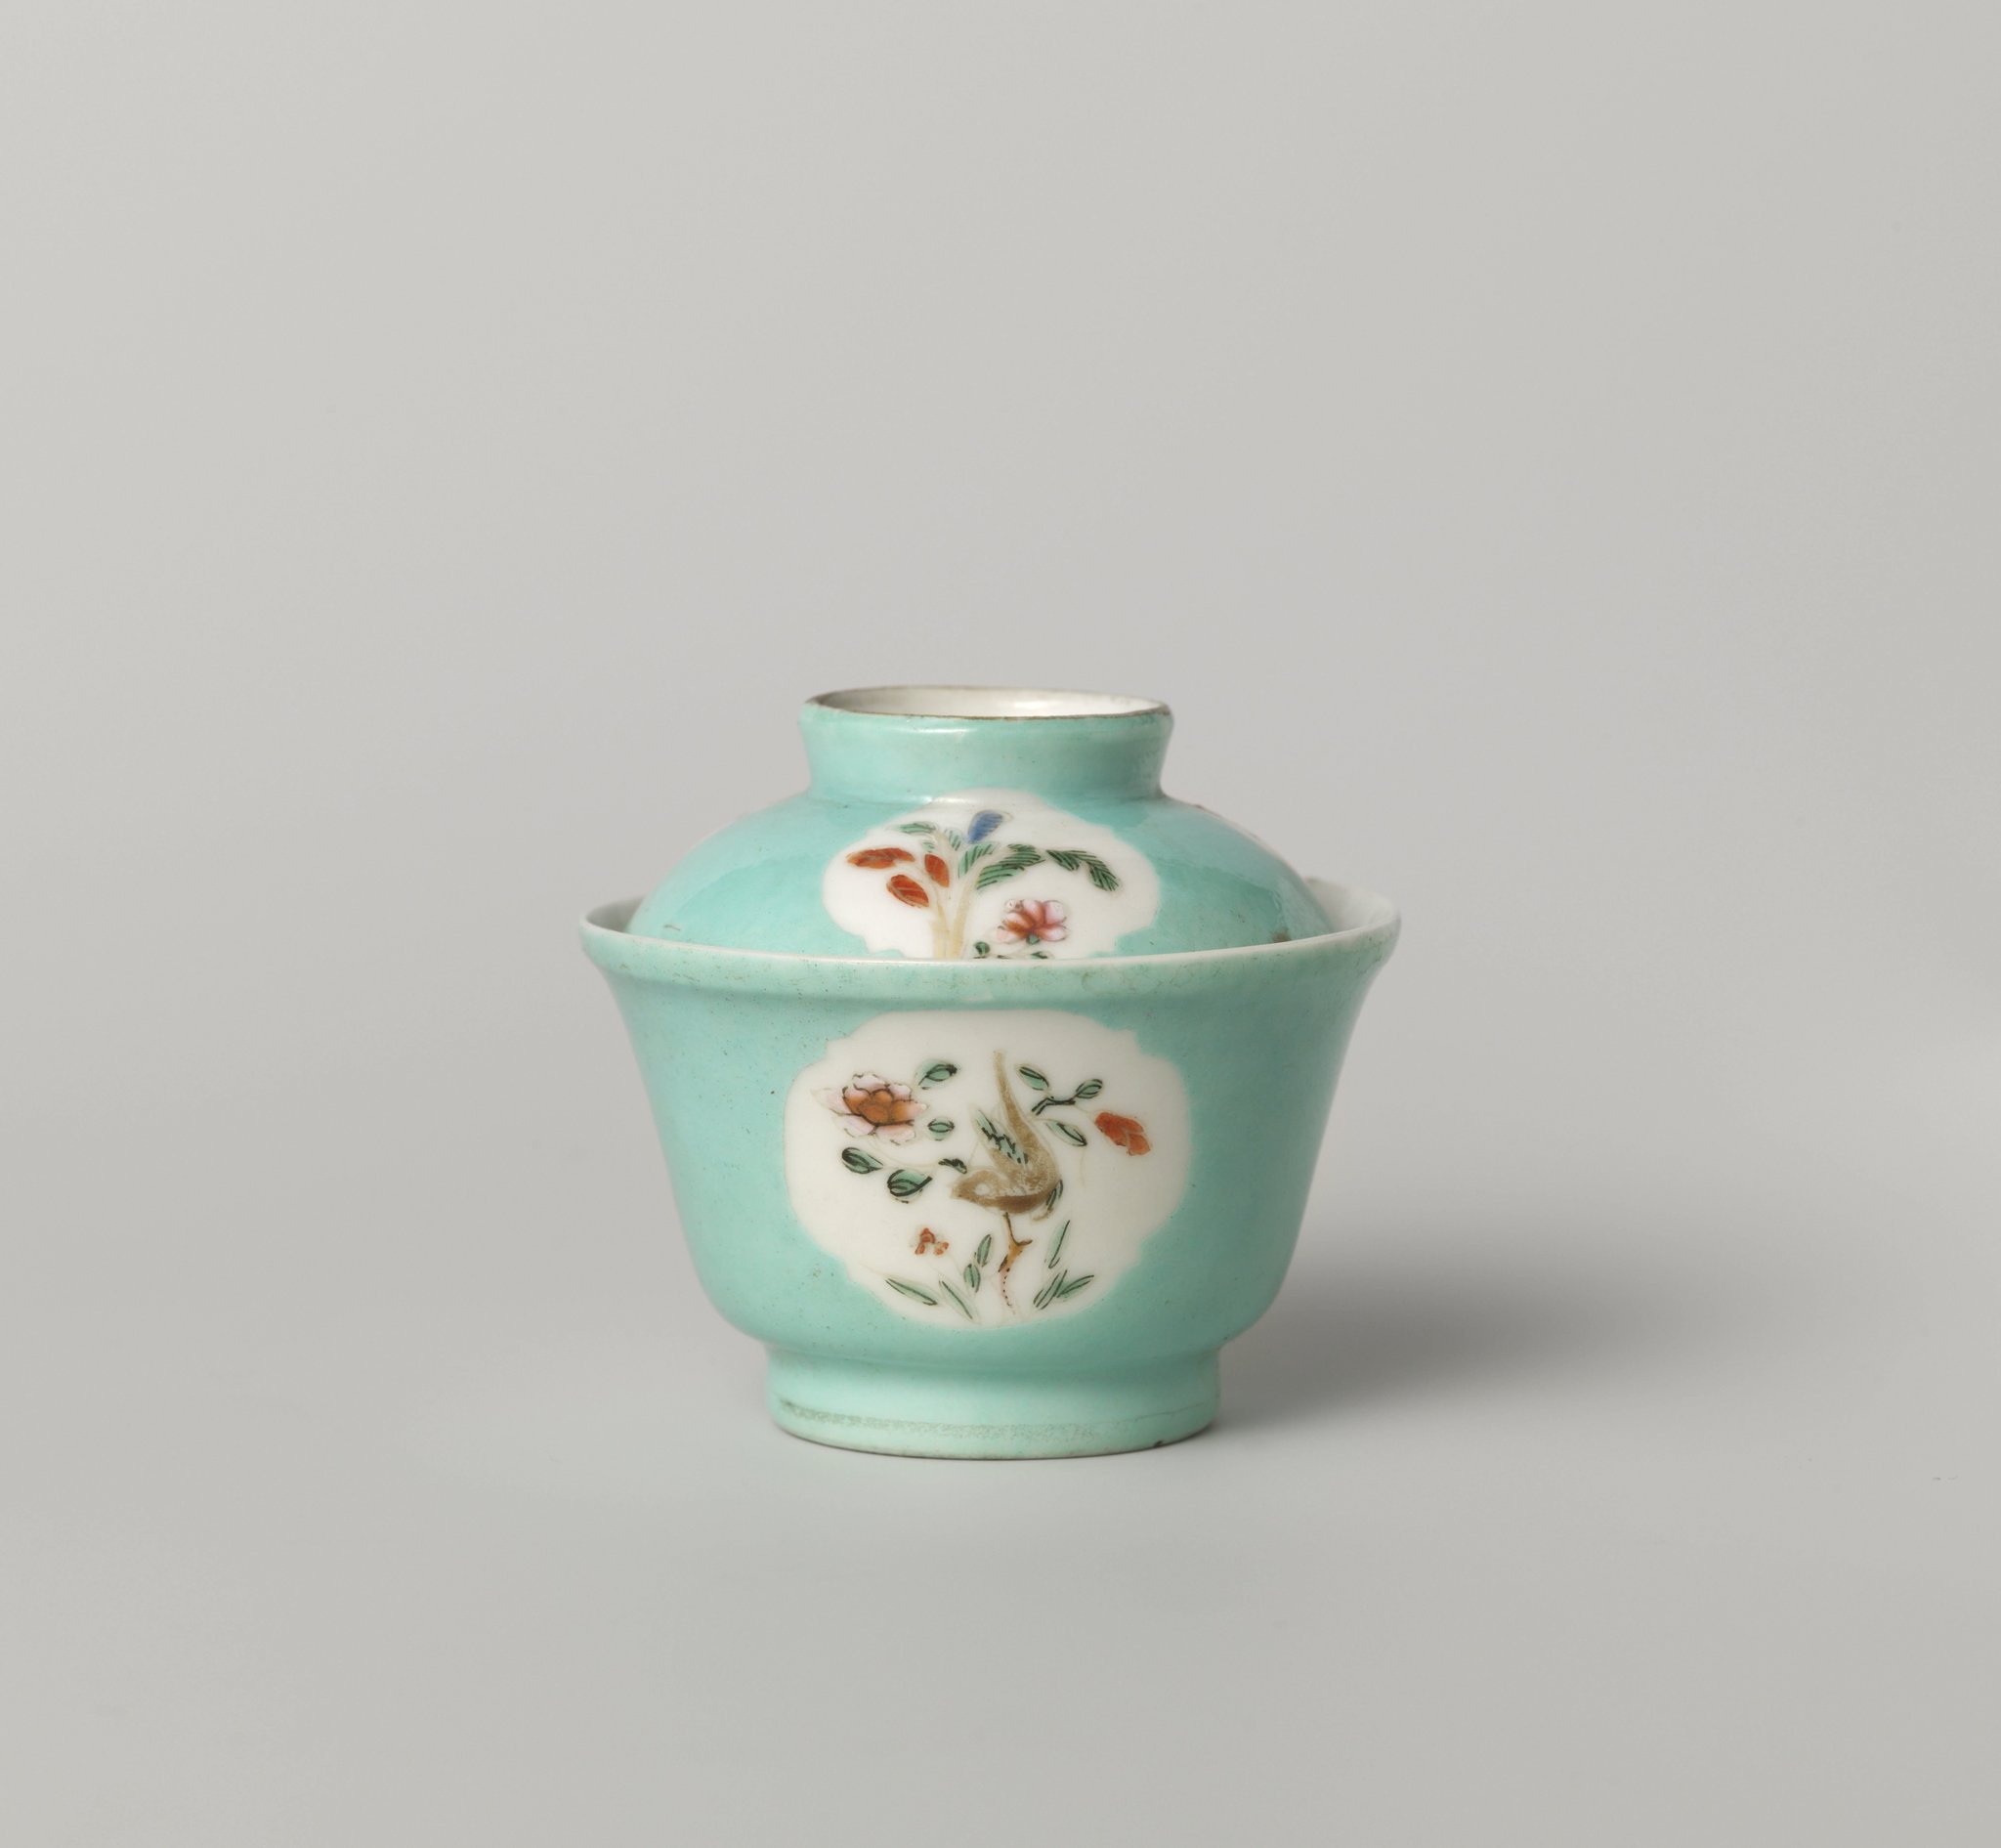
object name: kop en schotel, kop en schotel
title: Bell-shaped covered cup with flowering plants in shaped panels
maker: Anonymous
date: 1760-1780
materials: glaze, gold, paint, porcelain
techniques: firing, gilding, turning, vitrification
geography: china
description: Klokvormige kop van porselein, bedekt met een turquoise glazuur en berschilderd in blauw, rood, roze, groen, zwart en goud. Bedekt met een turquoise glazuur met hierin uitgespaard in het centrum een geschulpt medaillon met plant, daaromheen drie uitgespaarde cartouches met bloeiende planten en een vogel op een tak afgebeeld. Famille rose.